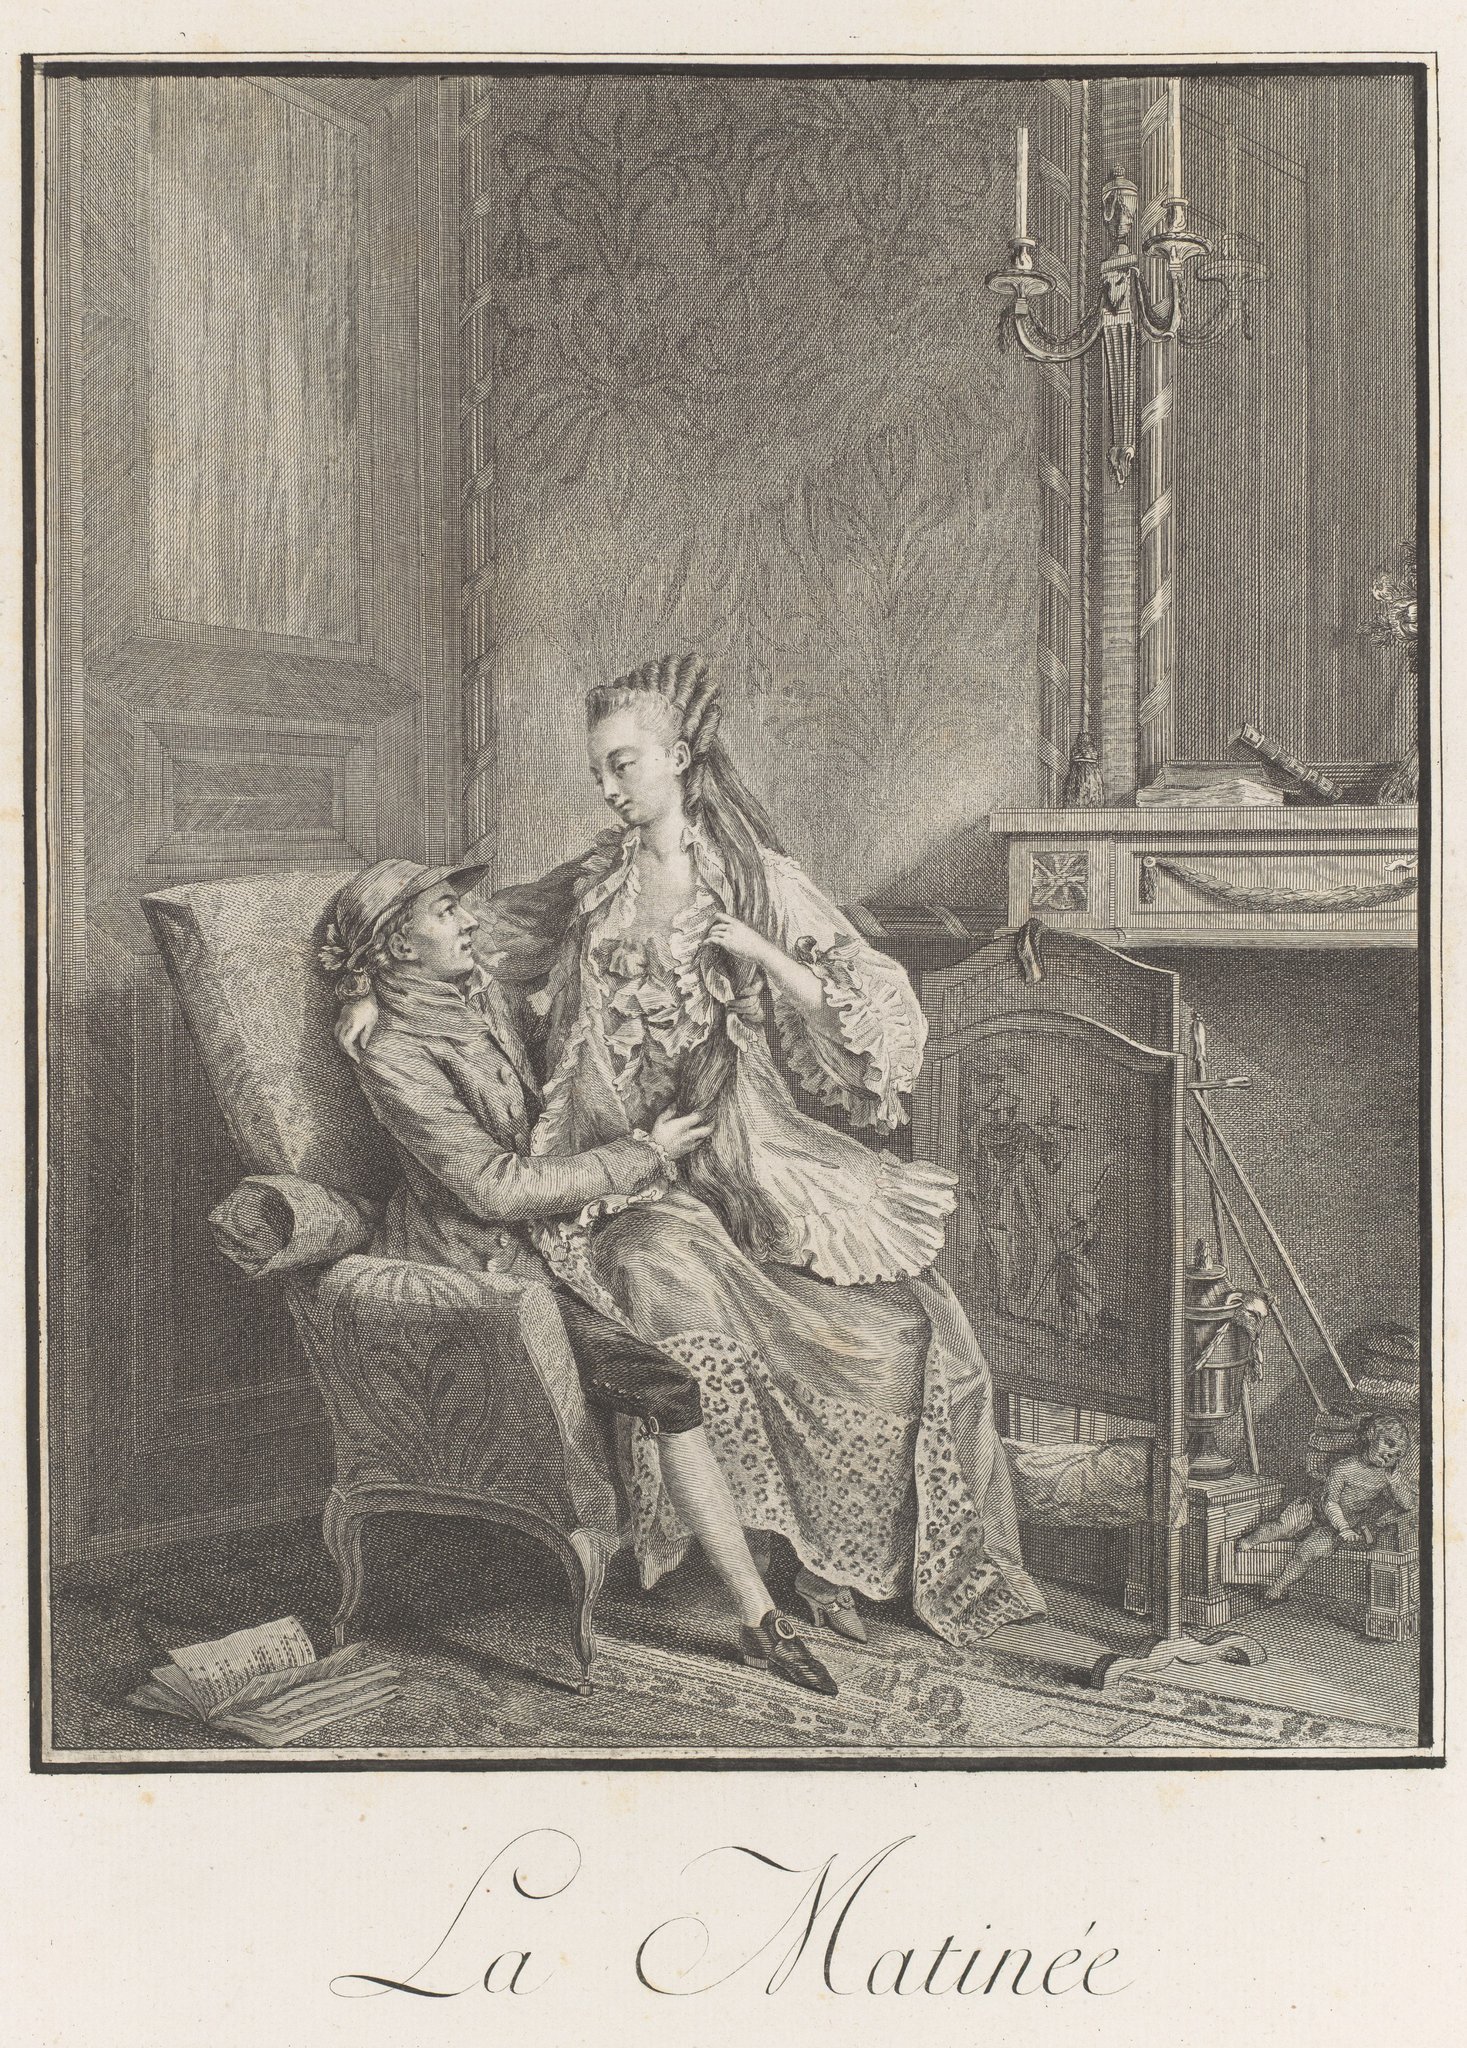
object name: print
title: La Matinée (L'heureuse Union)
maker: sigmond freudeberg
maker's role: artist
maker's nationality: swiss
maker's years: 1745-1801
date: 1789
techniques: etching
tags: couples,men,lovers,women